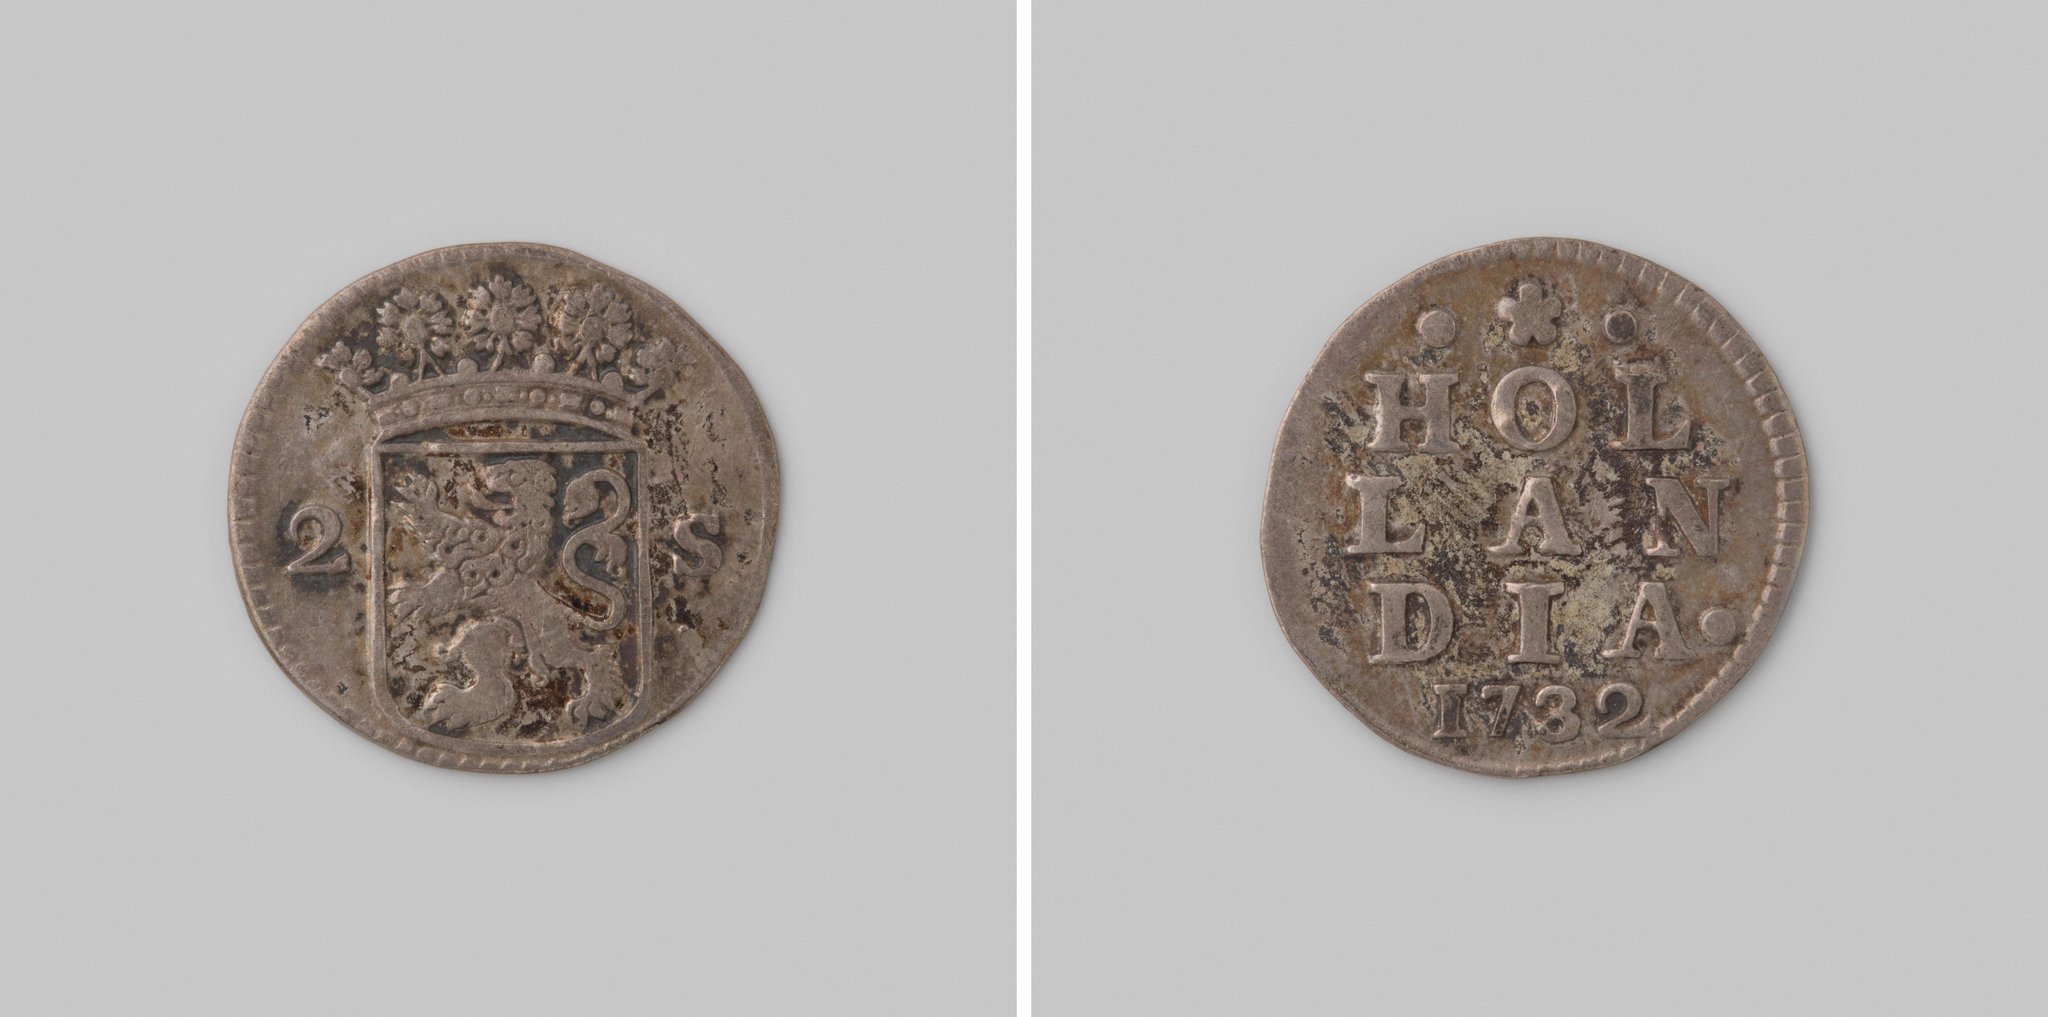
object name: coin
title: Holland, dubbele stuiver, 1732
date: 1732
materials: silver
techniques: striking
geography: dordrecht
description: Zilveren munt. Voorzijde: tussen waarde-aanduiding 2 S gekroond wapenschild van Holland. Keerzijde: opschrift: provincienaam in drie regels, daaronder jaartal.